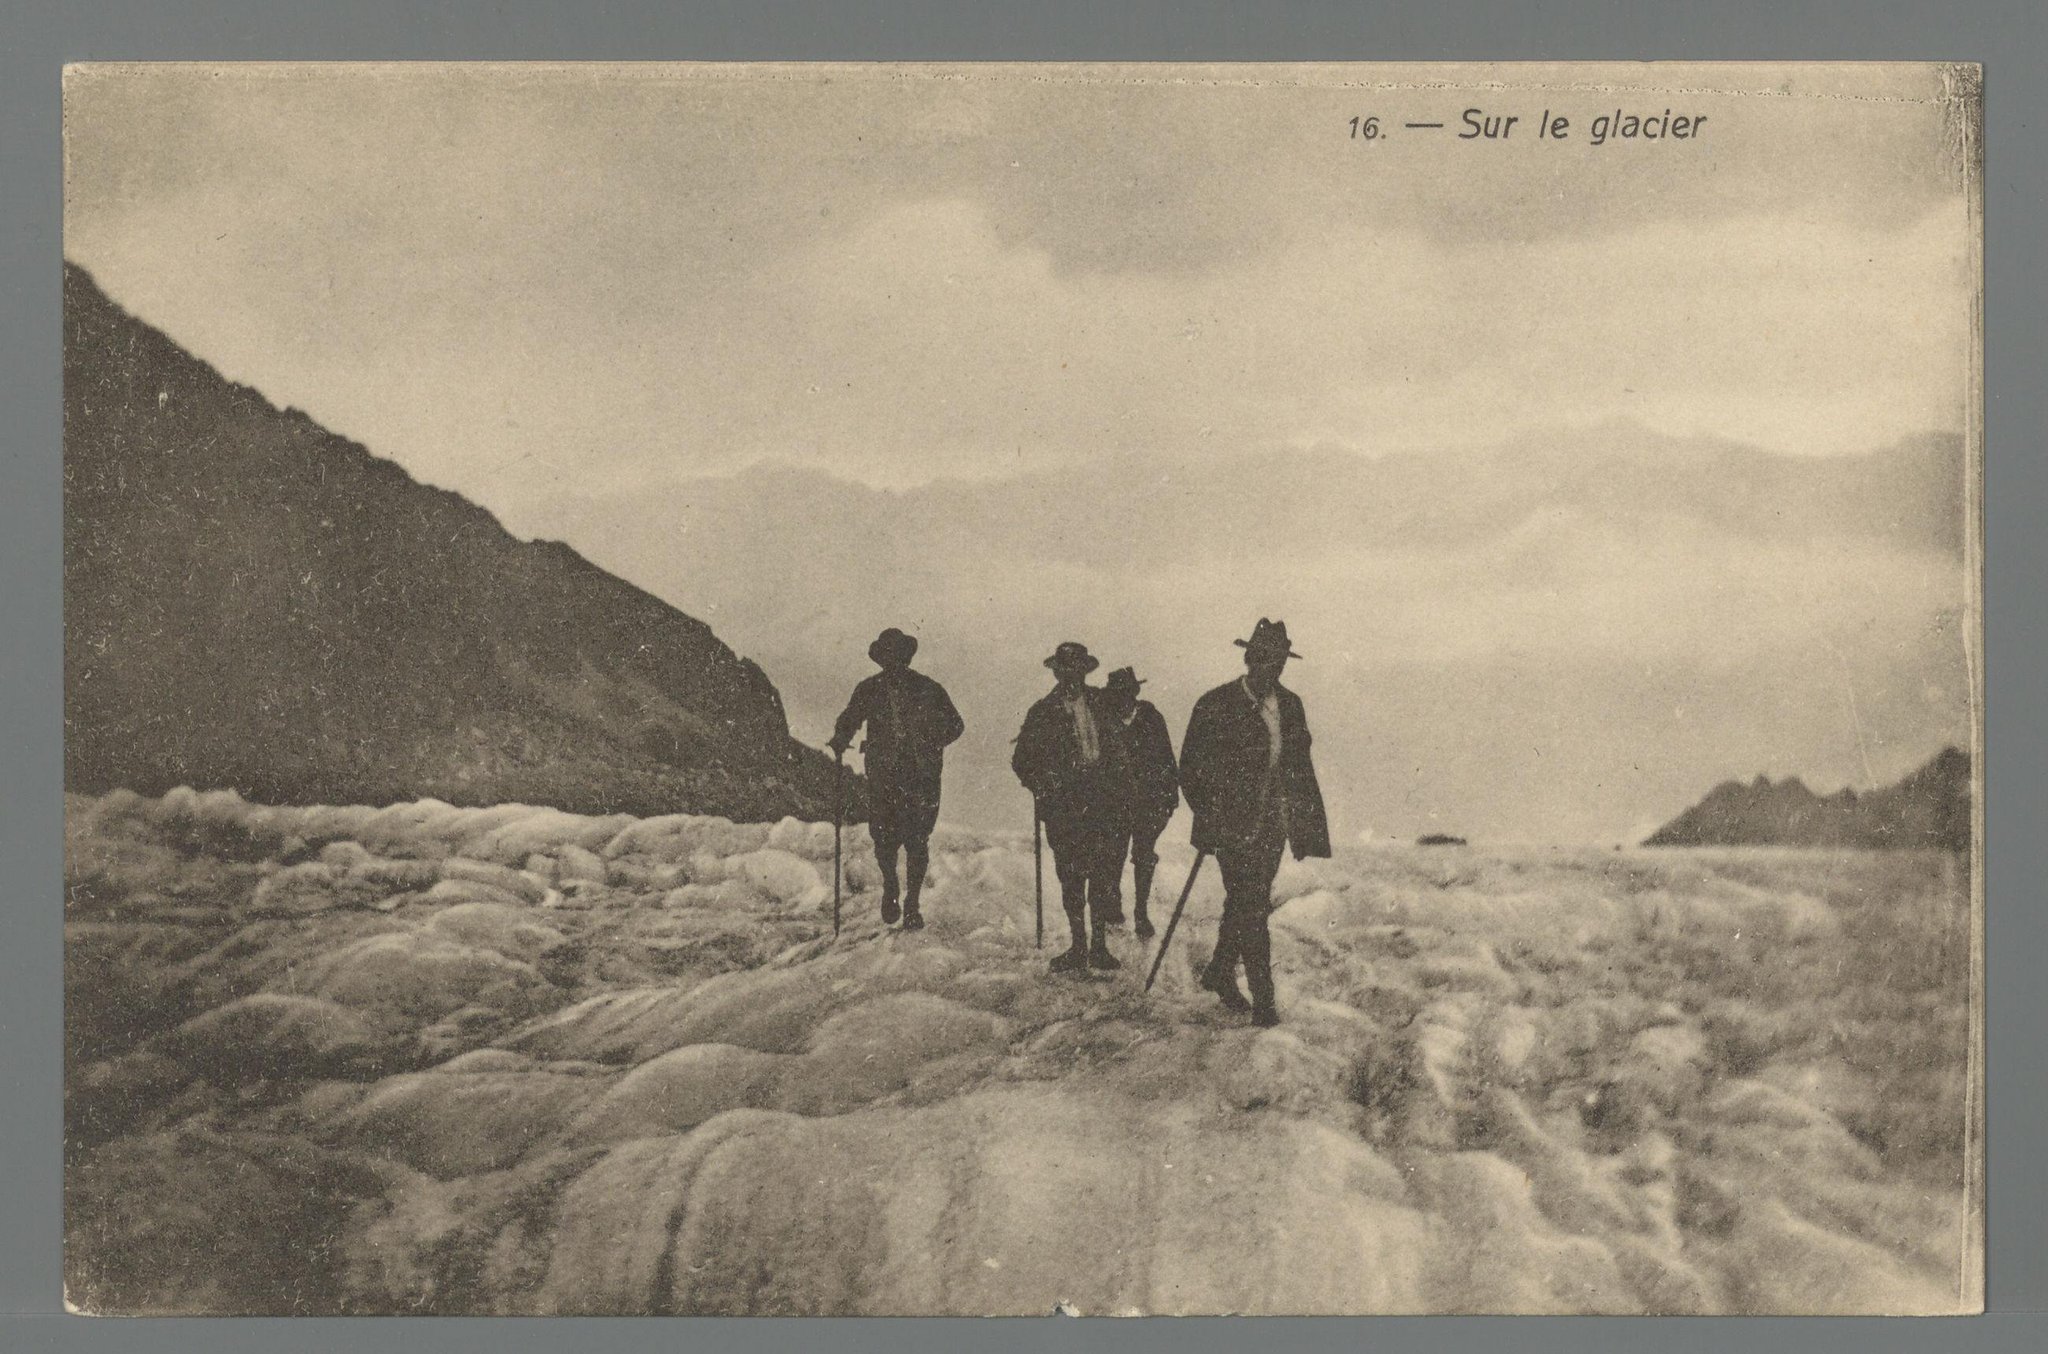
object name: photomechanical print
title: Sur le glacier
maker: Anonymous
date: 1905-1909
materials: cardboard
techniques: photograph, writing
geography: switzerland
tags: glacier (+ landscape with figures, staffage), switzerland